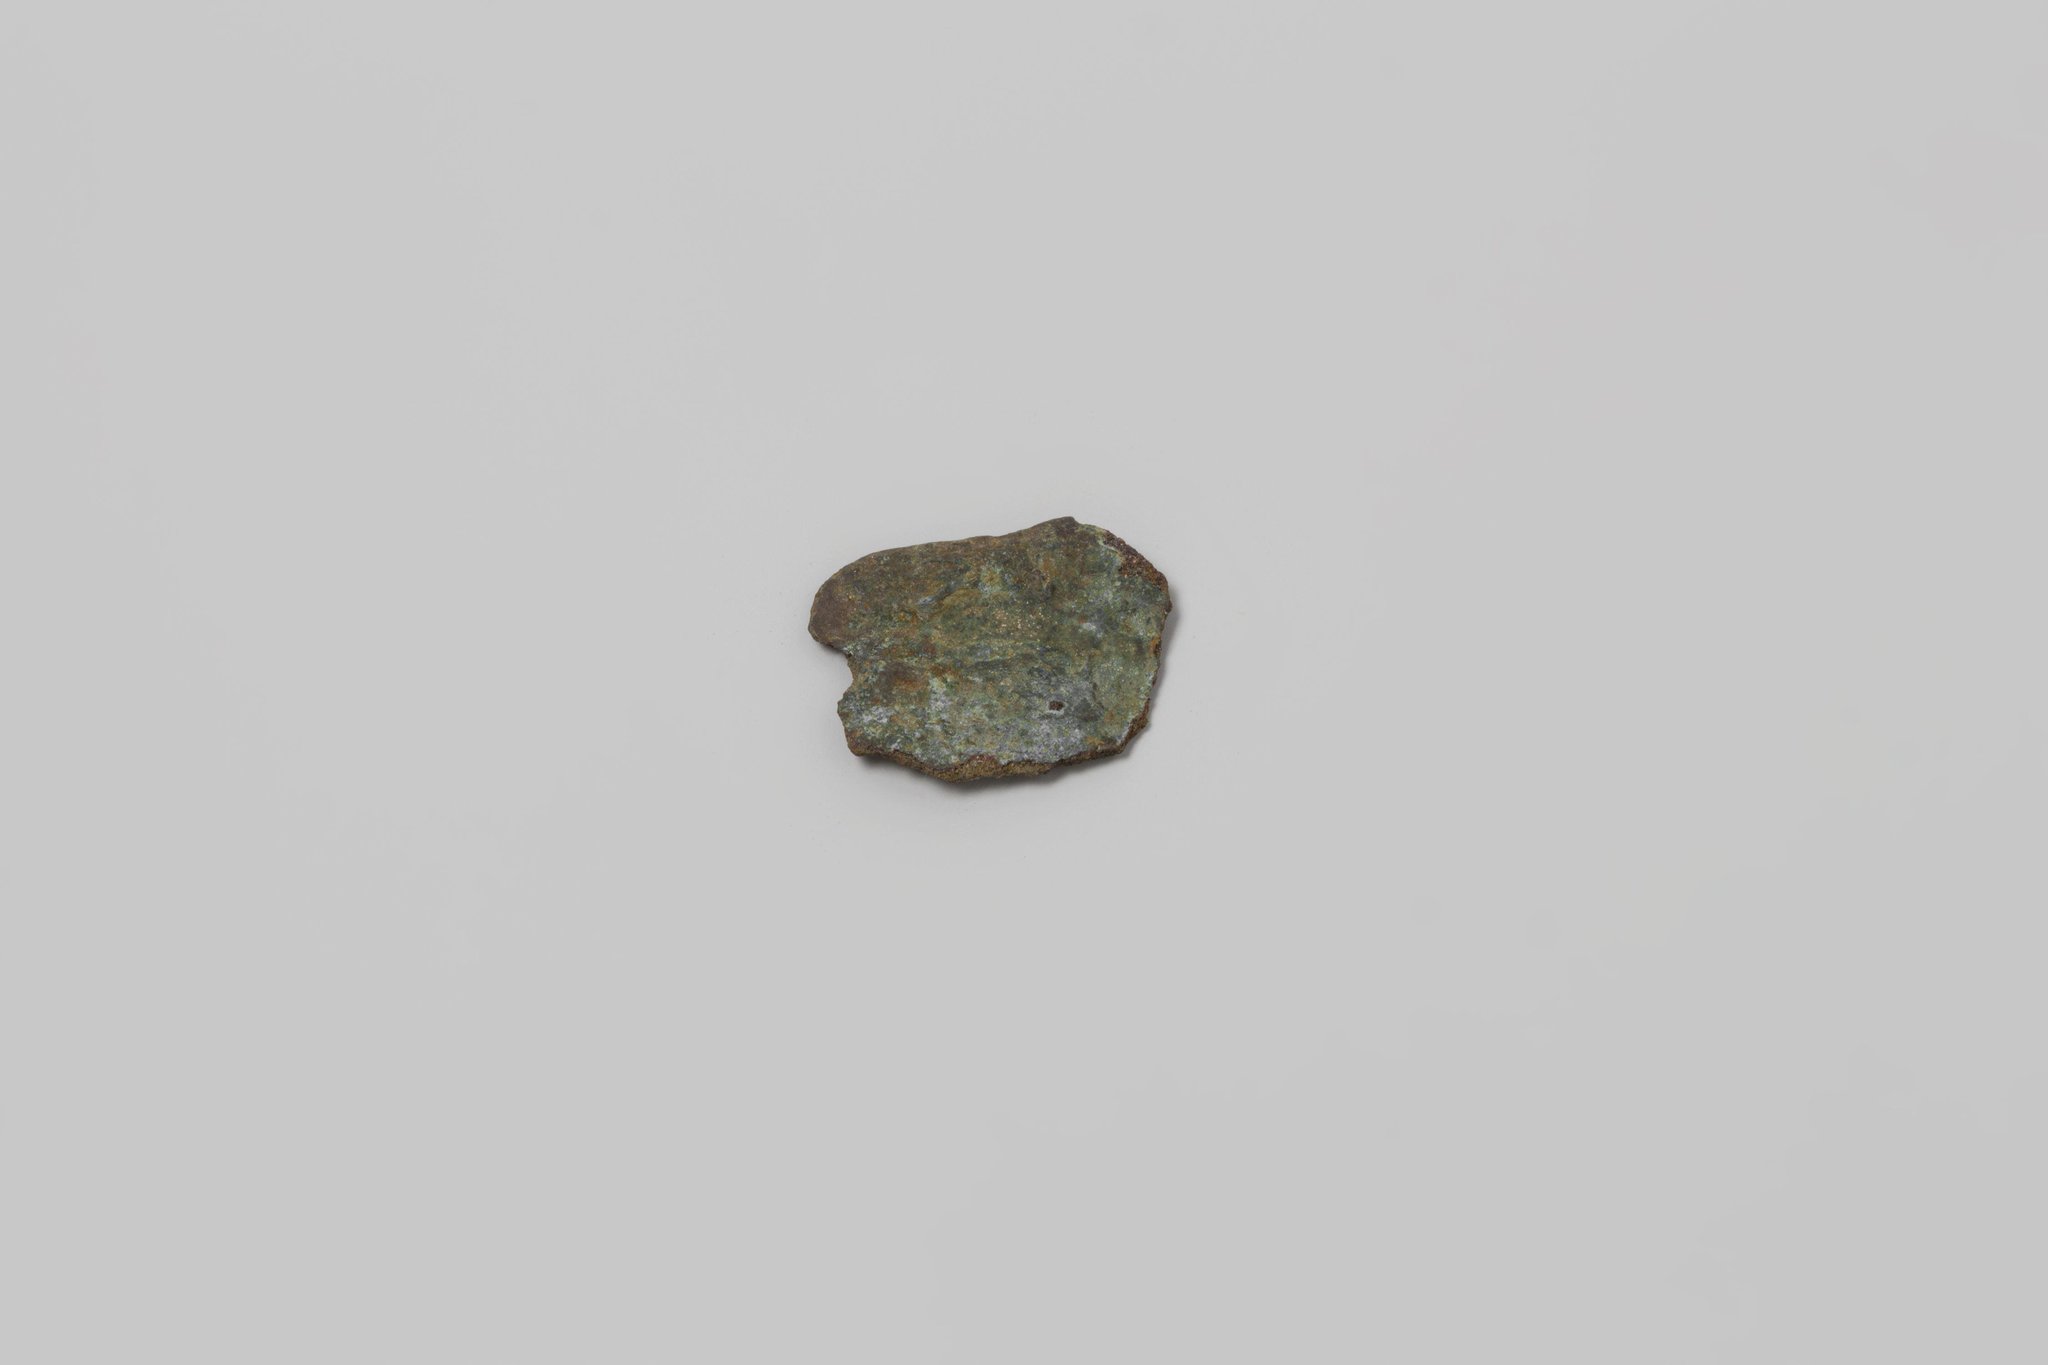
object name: fragment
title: Fragment koper uit het wrak van de Oost-Indiëvaarder Hollandia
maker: Anonymous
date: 1700-1743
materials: copper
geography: netherlands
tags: verenigde oostindische compagnie, hollandia (schip), annet